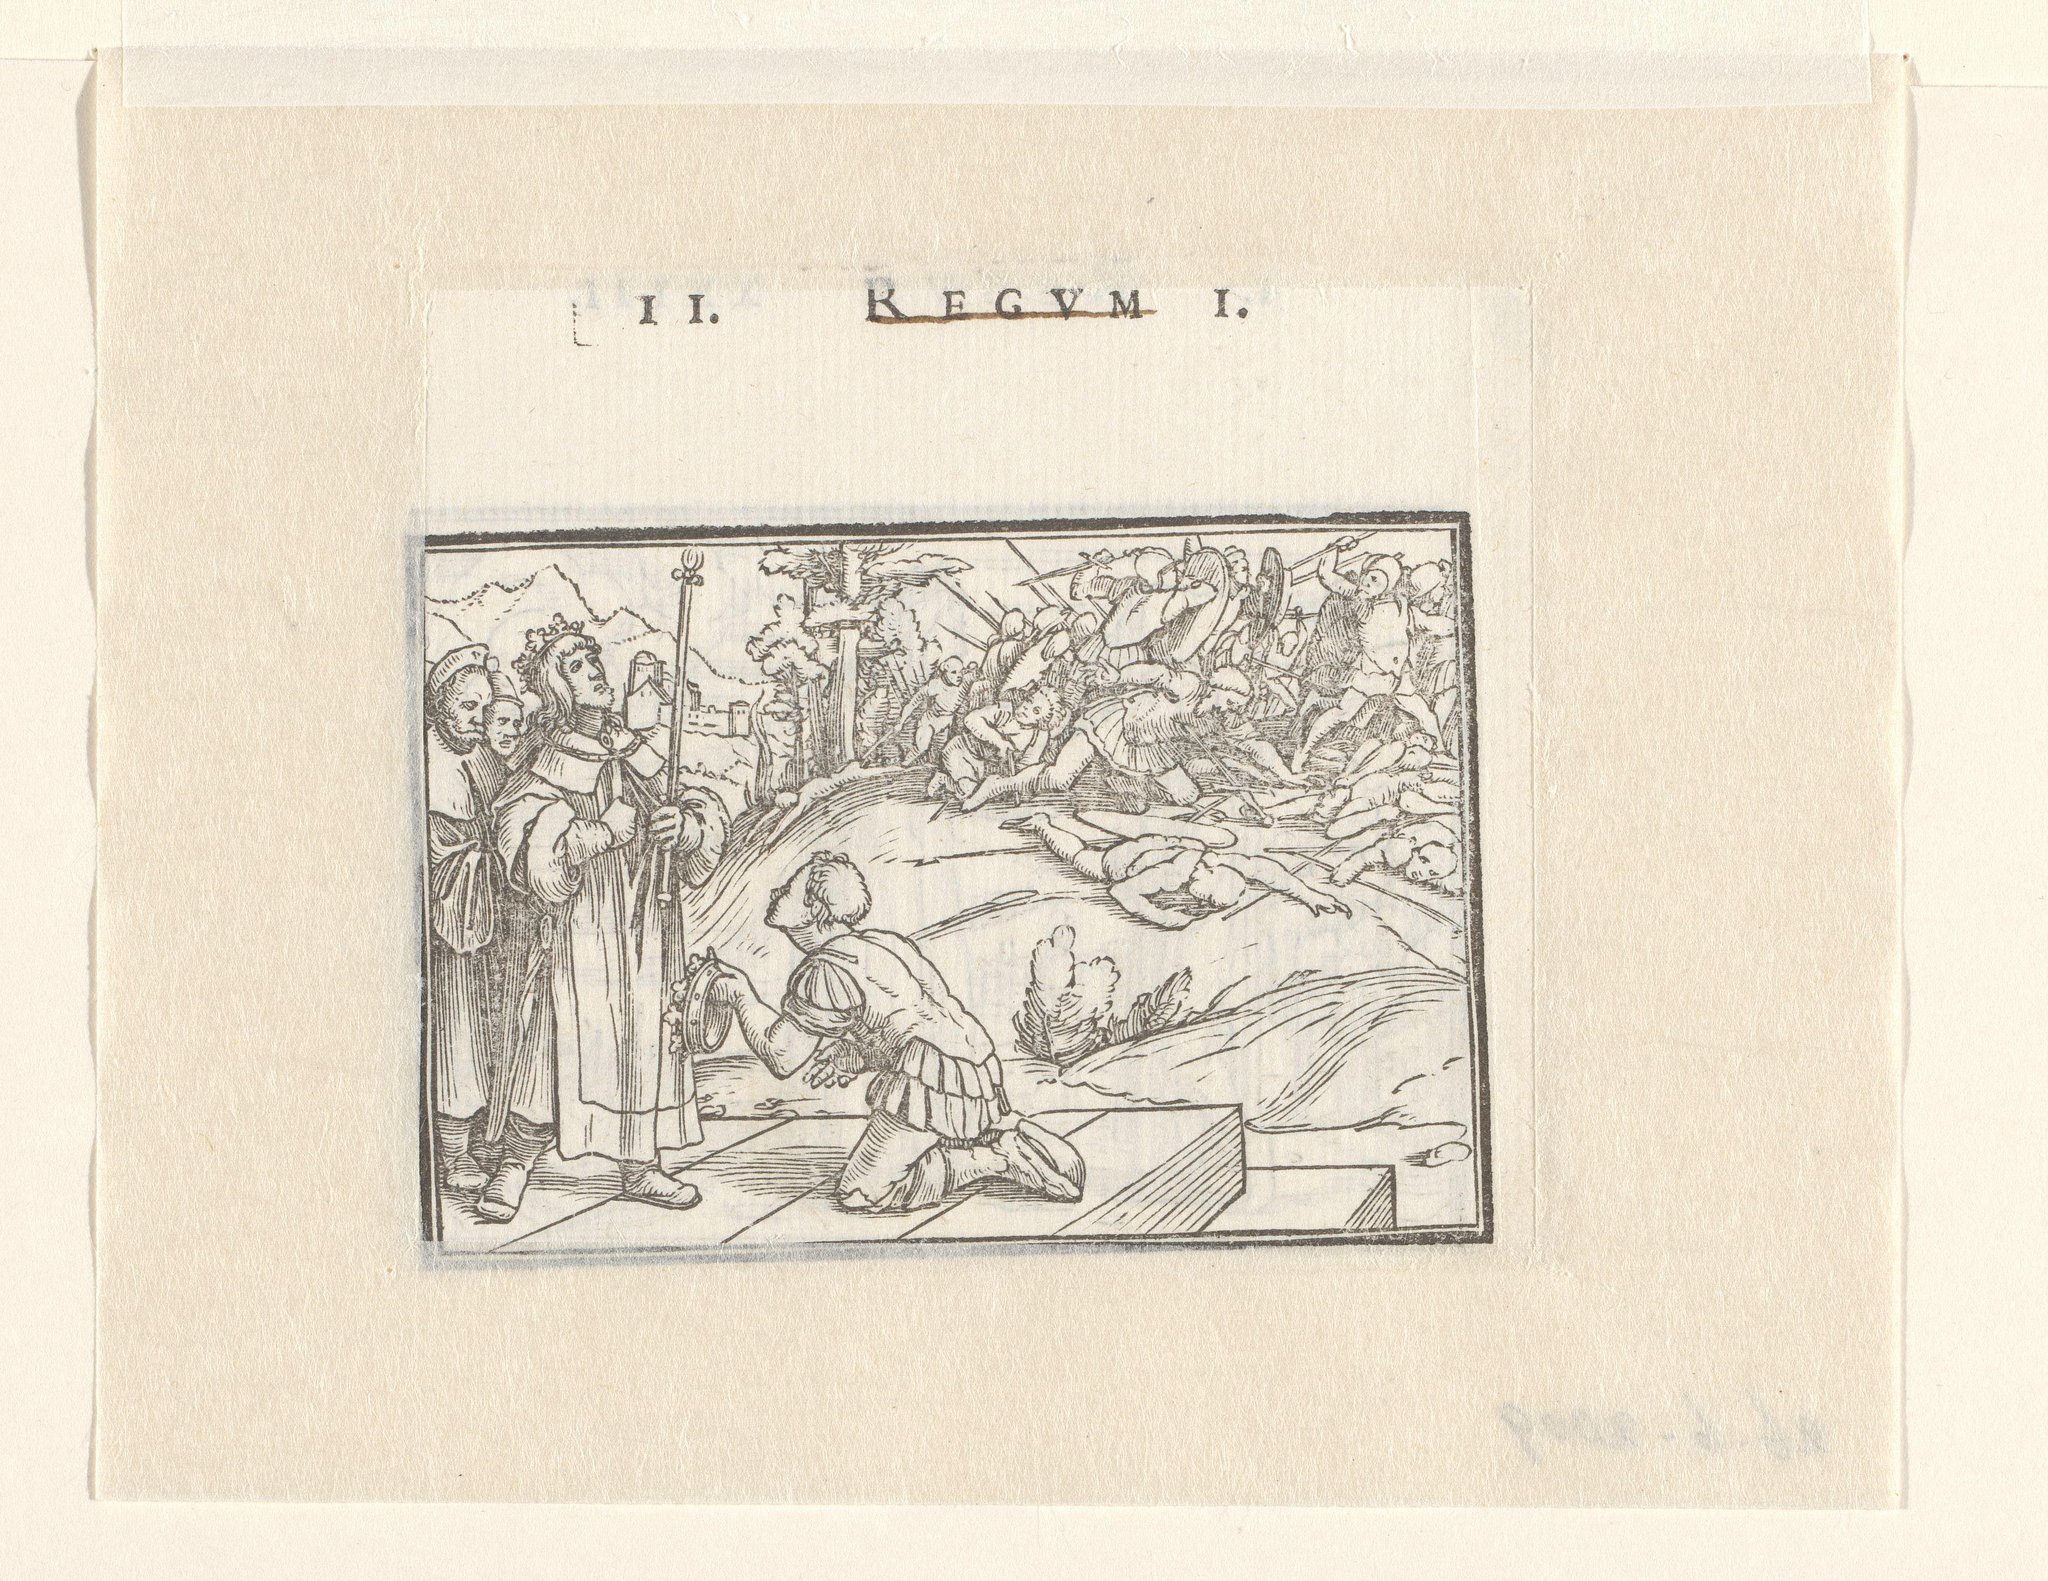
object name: book illustration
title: Man uit legerkamp van Israël met kroon van Saul voor David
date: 1538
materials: paper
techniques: woodcut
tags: a messenger brings the tidings of saul's (and jonathan's) death to david; the messenger falls prostrate to the ground before david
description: Houtblok voor het eerst gebruikt in: Biblia Utriusque Testamenti iuxta Vulgatam Translationem, Lyon, M. en G. Trechsel (voor Hugo à Porta) 1538. Later in verschillende uitgaven opnieuw gebruikt.